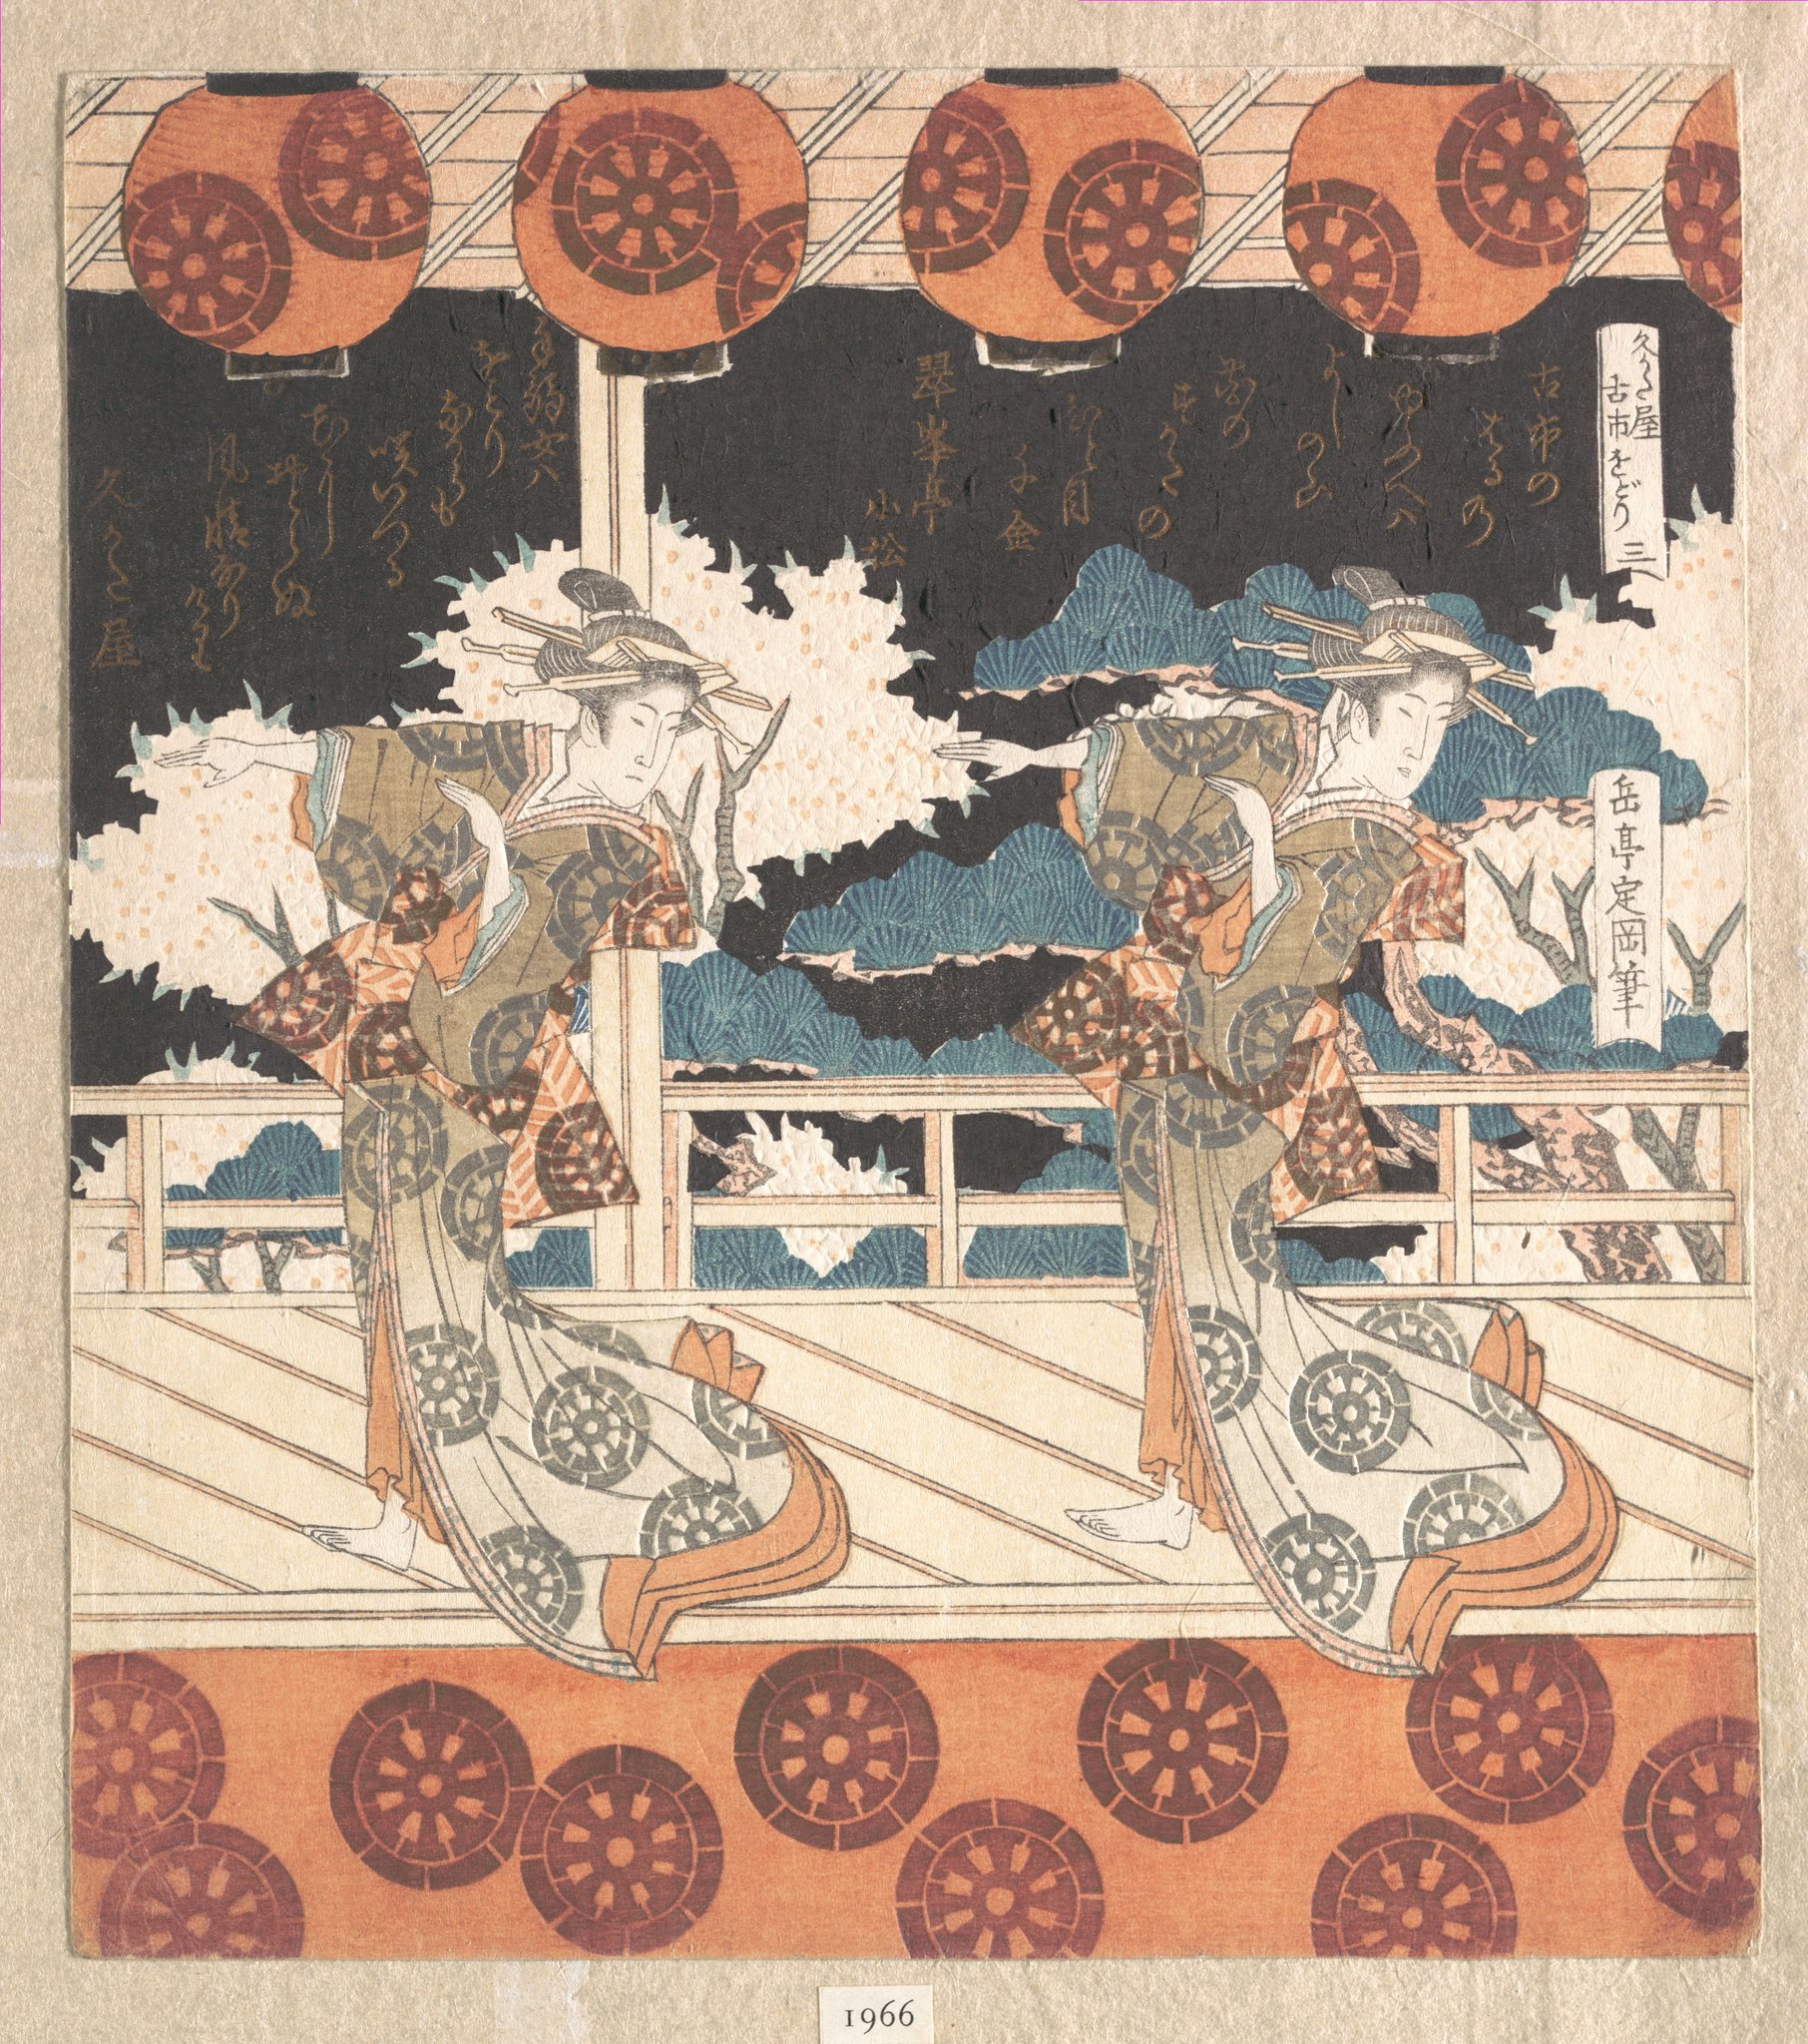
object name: print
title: Furuichi Dance (No. 3 of a Set of Four)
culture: japanese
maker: yashima gakutei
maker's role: artist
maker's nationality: japanese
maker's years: 1786-1868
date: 1801-1900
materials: ink, paper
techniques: surimono, woodblock print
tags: women,dancing